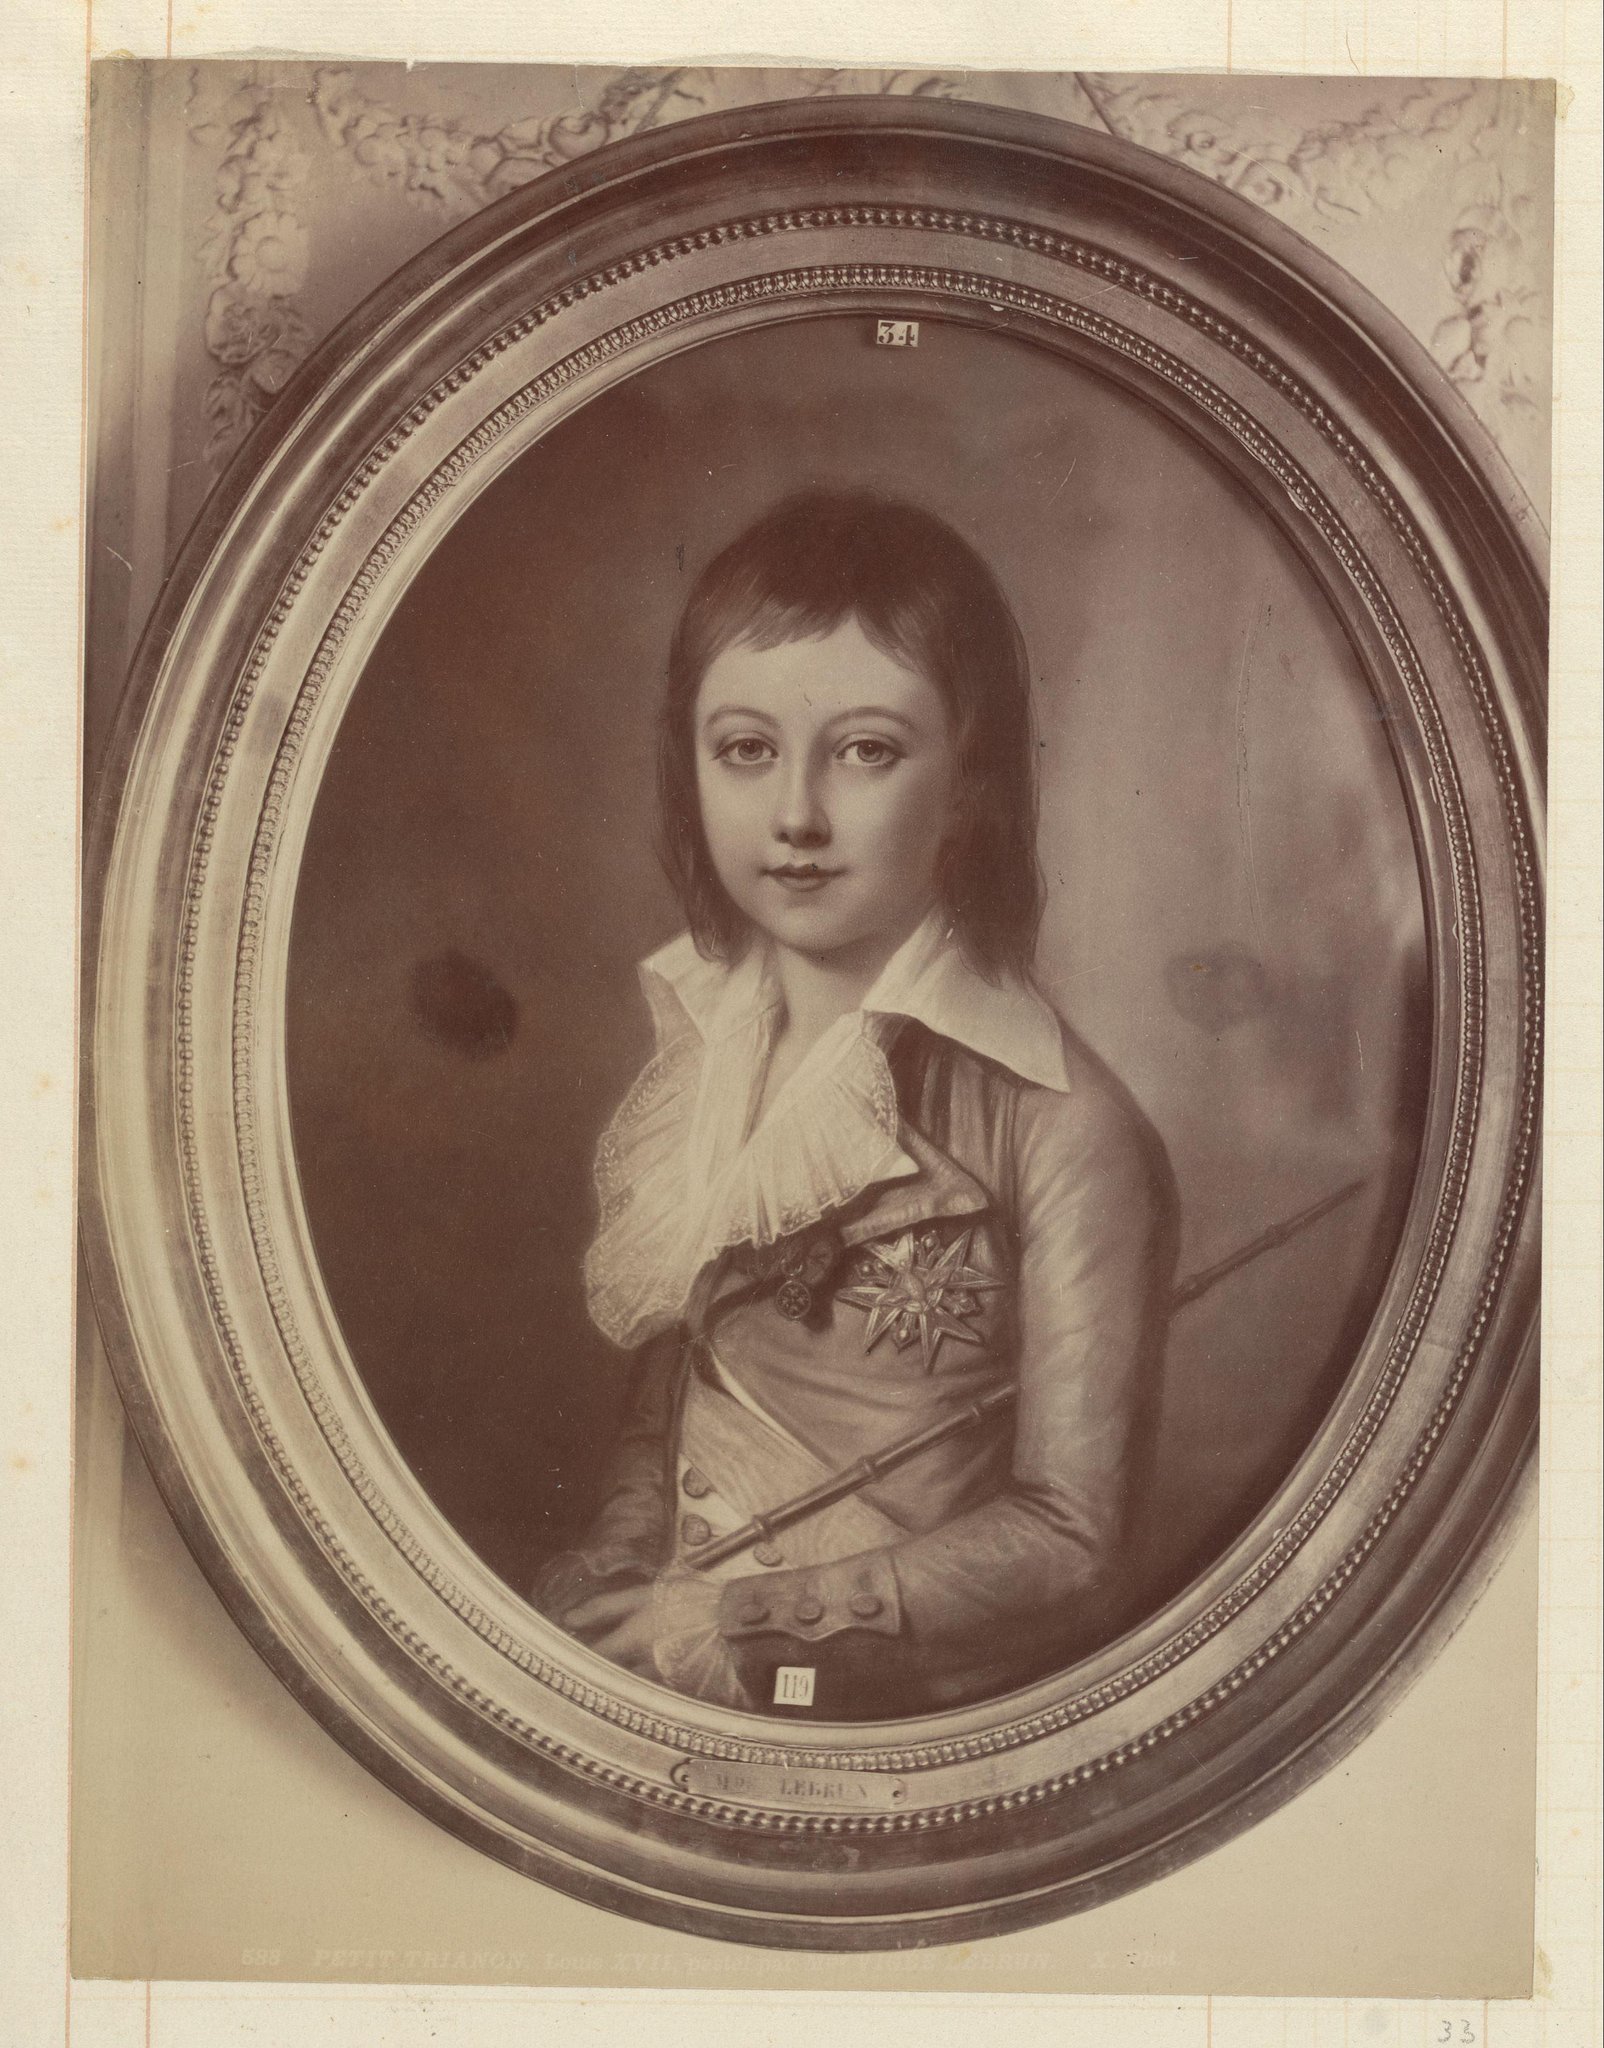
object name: photograph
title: Petit Trianon. Louis XVII pastel par Mme Vigée Lebrun X. Phot.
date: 1880-1900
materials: paper, photographic support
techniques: albumen print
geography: france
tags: youth, adolescent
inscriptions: negative number: ‘588’